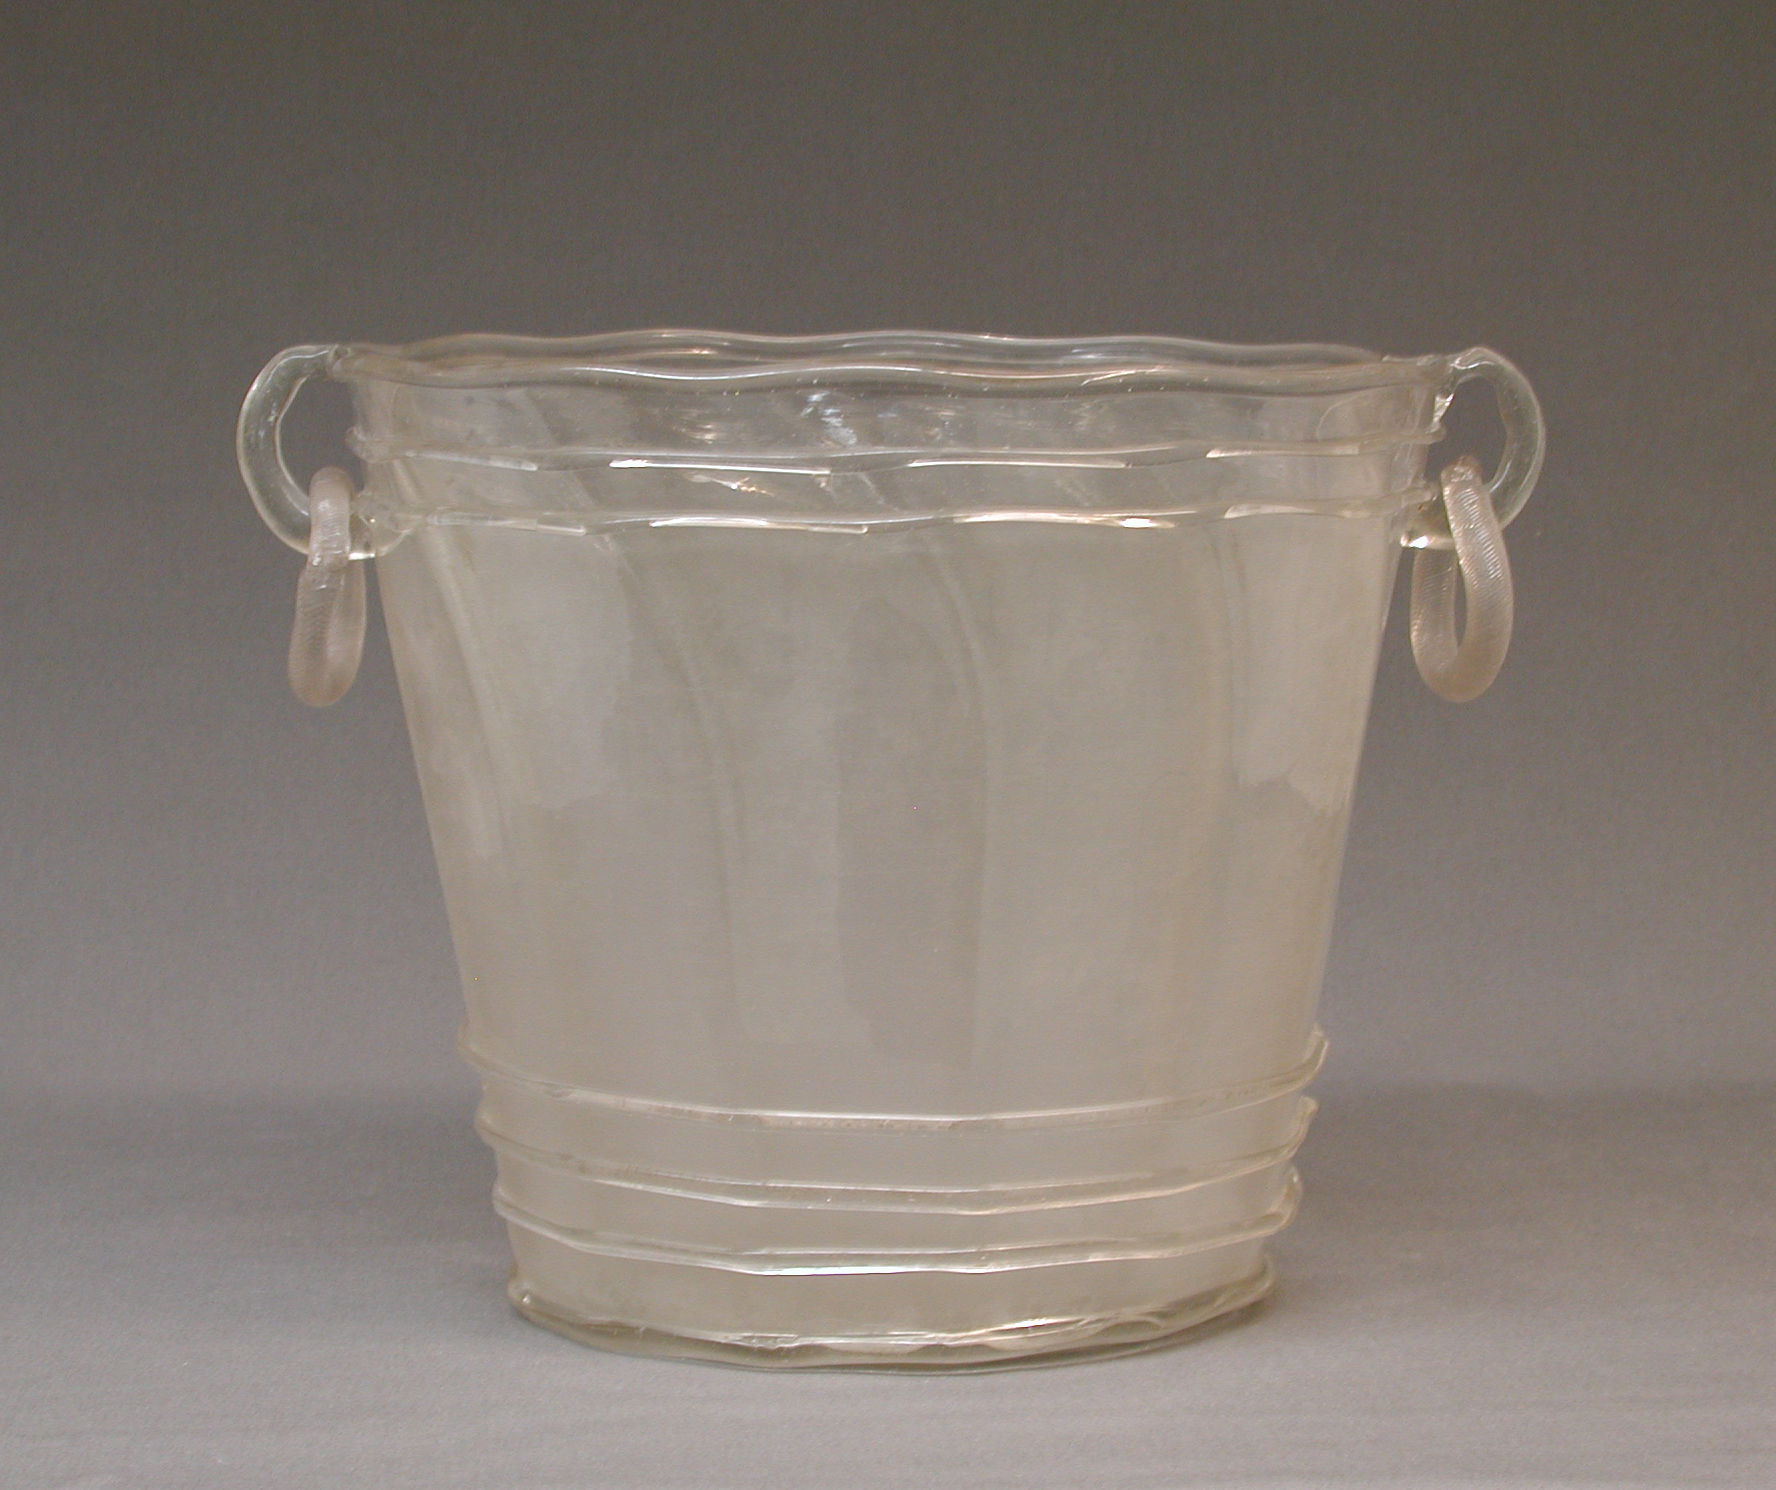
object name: pail or cistern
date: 1701-1800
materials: glass